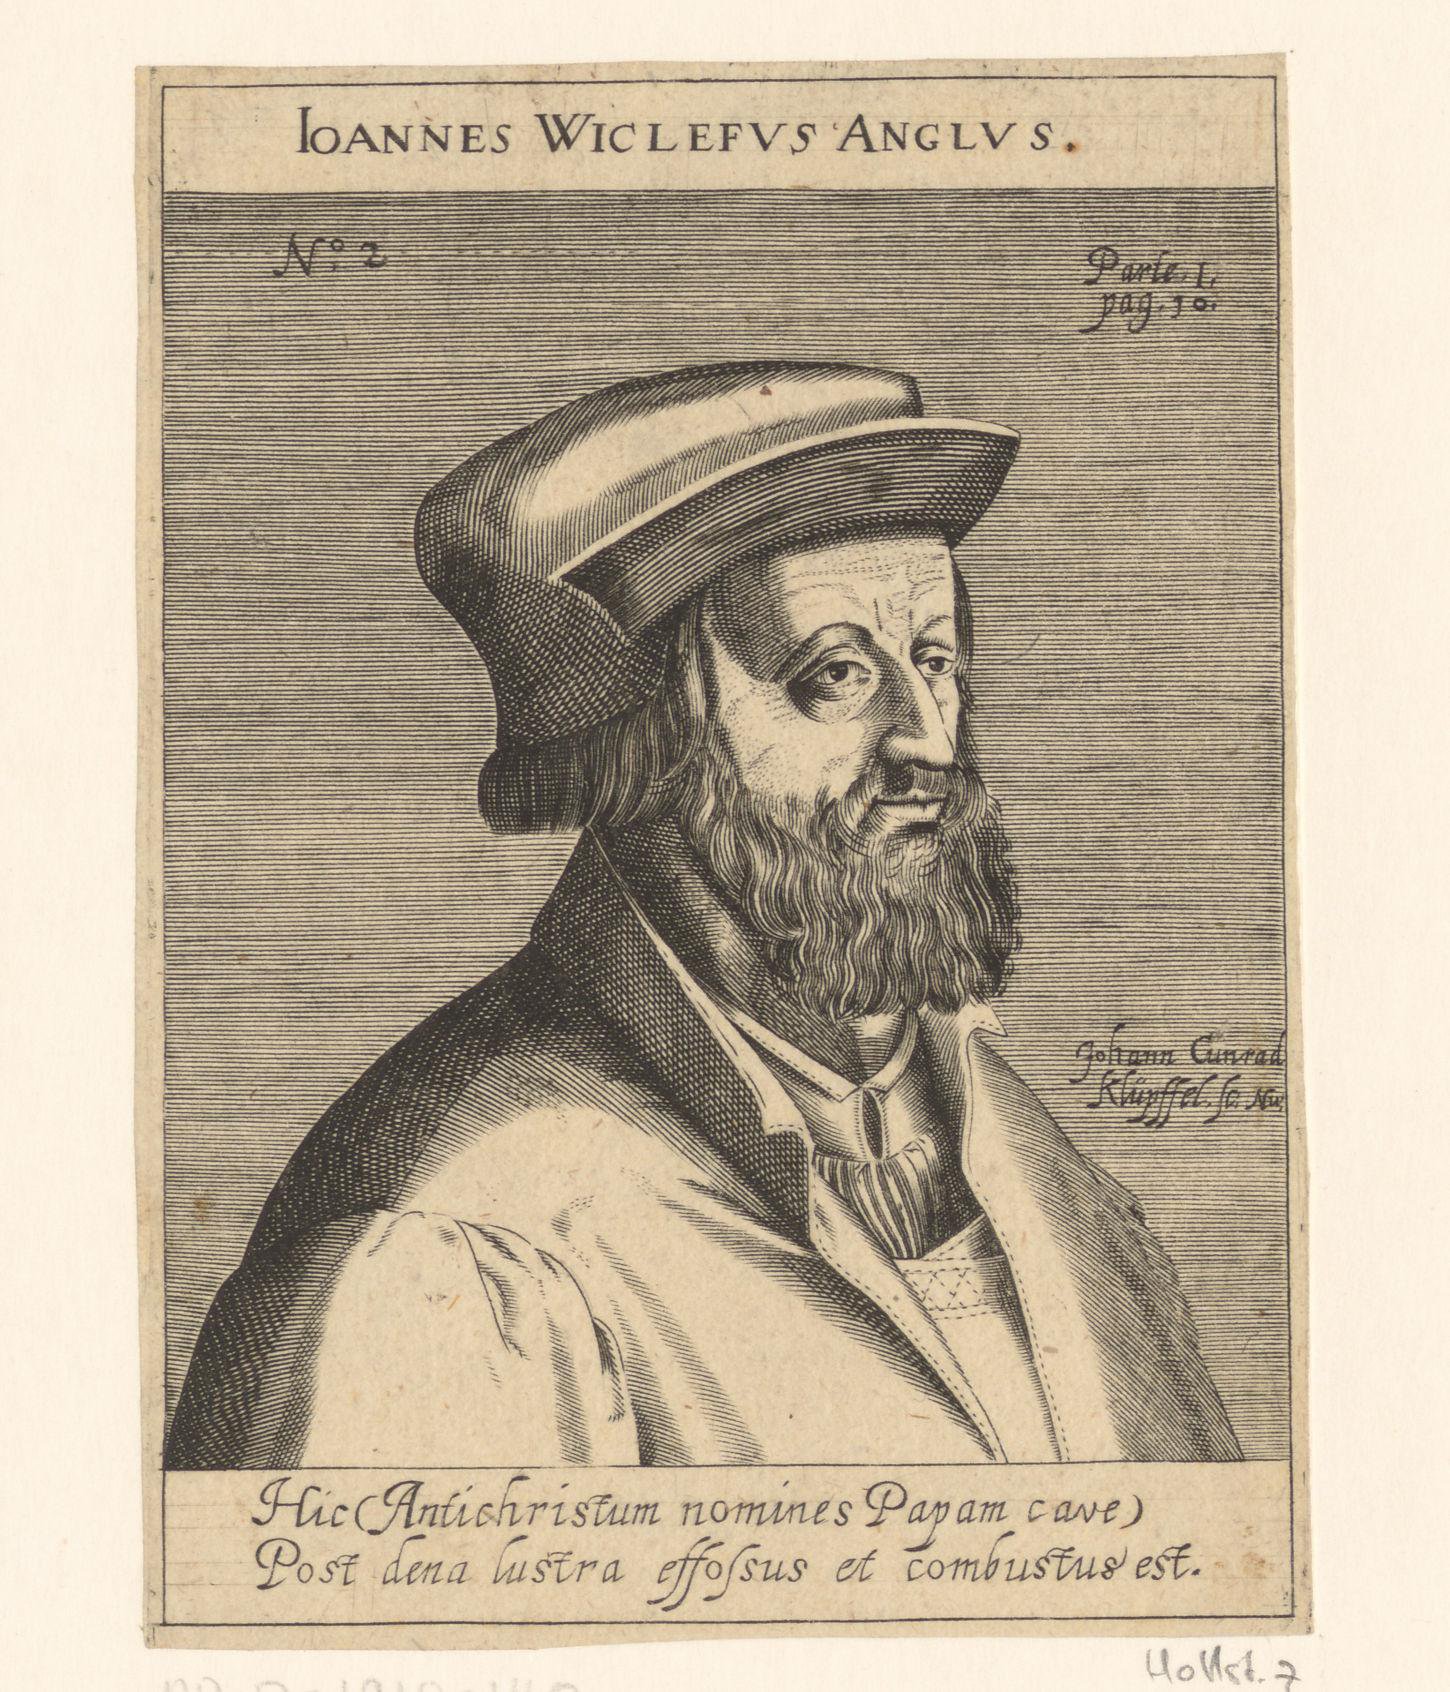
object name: print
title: Portret van Johannes Engel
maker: johann conrad klüpfel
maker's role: print maker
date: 1621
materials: paper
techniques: engraving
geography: nuremberg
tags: vienna, astronomy (and cosmography) (+ portrait of scholar, scientist), further education (+ portrait of teacher, professor), historical persons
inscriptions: collector's mark: Lugt 2228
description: Dit is een van de veertien prenten door Johann Conrad Klüpfel, gebruikt in: Theobald, Zacharias. Bellum hussiticum. Frankfurt: s.n., 1621.